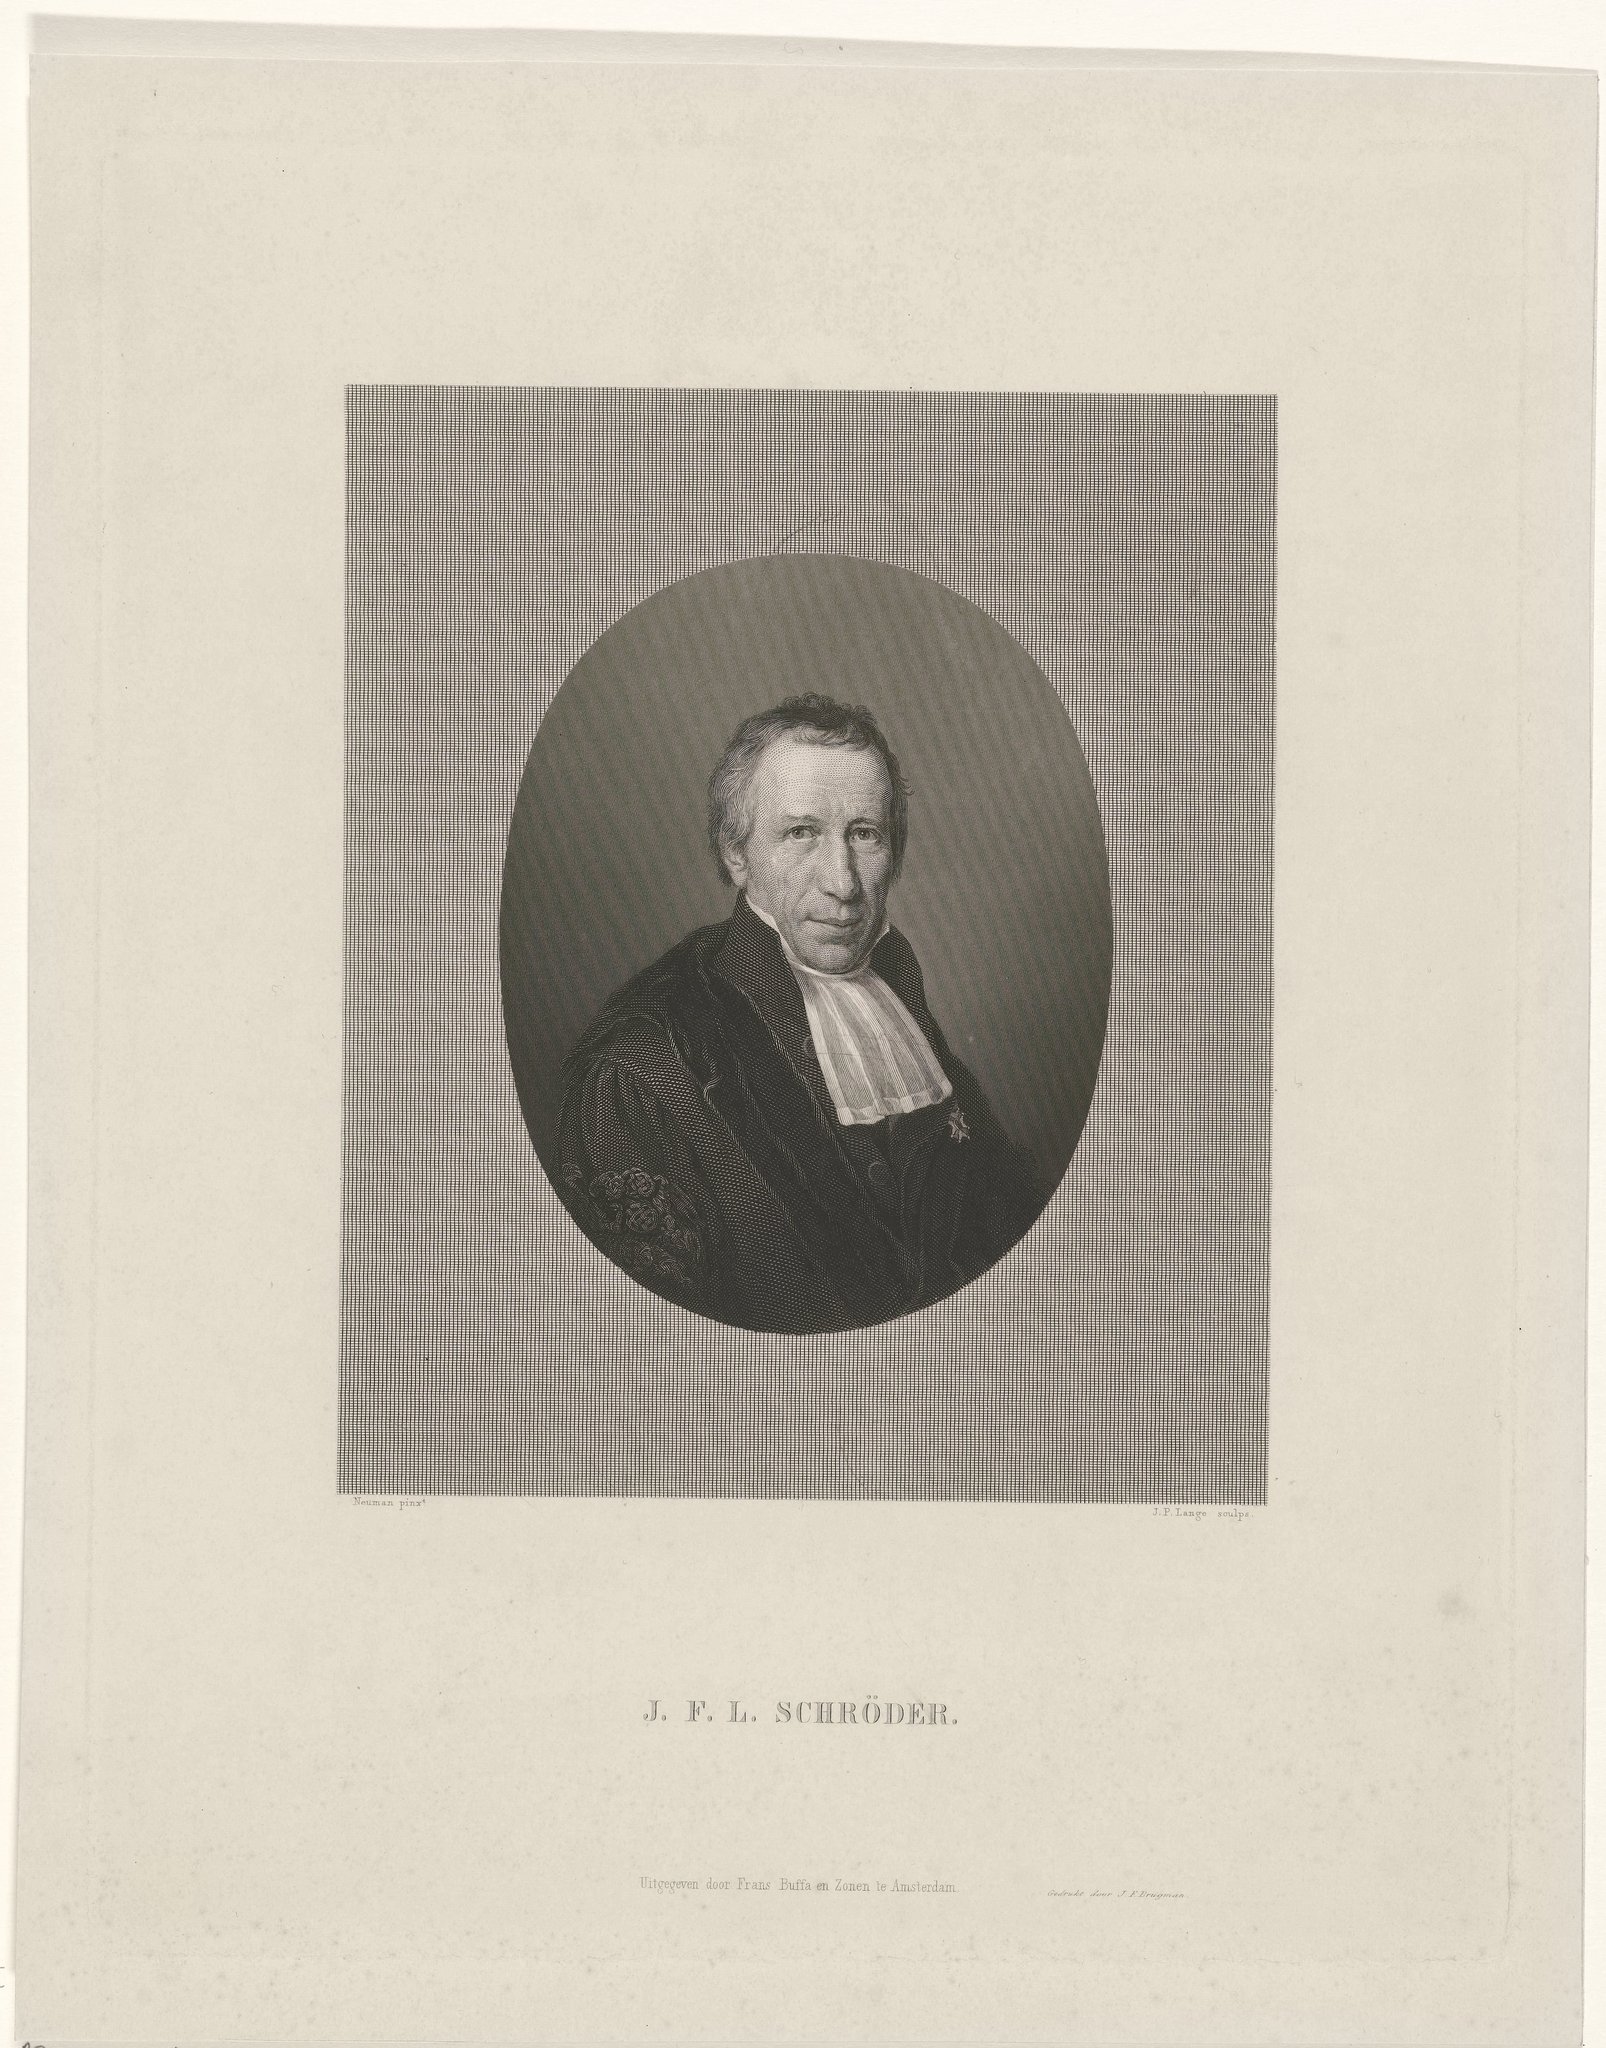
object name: print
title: Portret van Johannes Frederik Lodewijk Schröder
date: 1820-1849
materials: paper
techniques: engraving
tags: utrecht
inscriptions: collector's mark: Lugt 2228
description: Portretbuste in ovaal naar rechts van Johannes Frederik Lodewijk Schröder, theoloog, wis- en natuurkundige, in toga met bef en ridderorde op de borst..